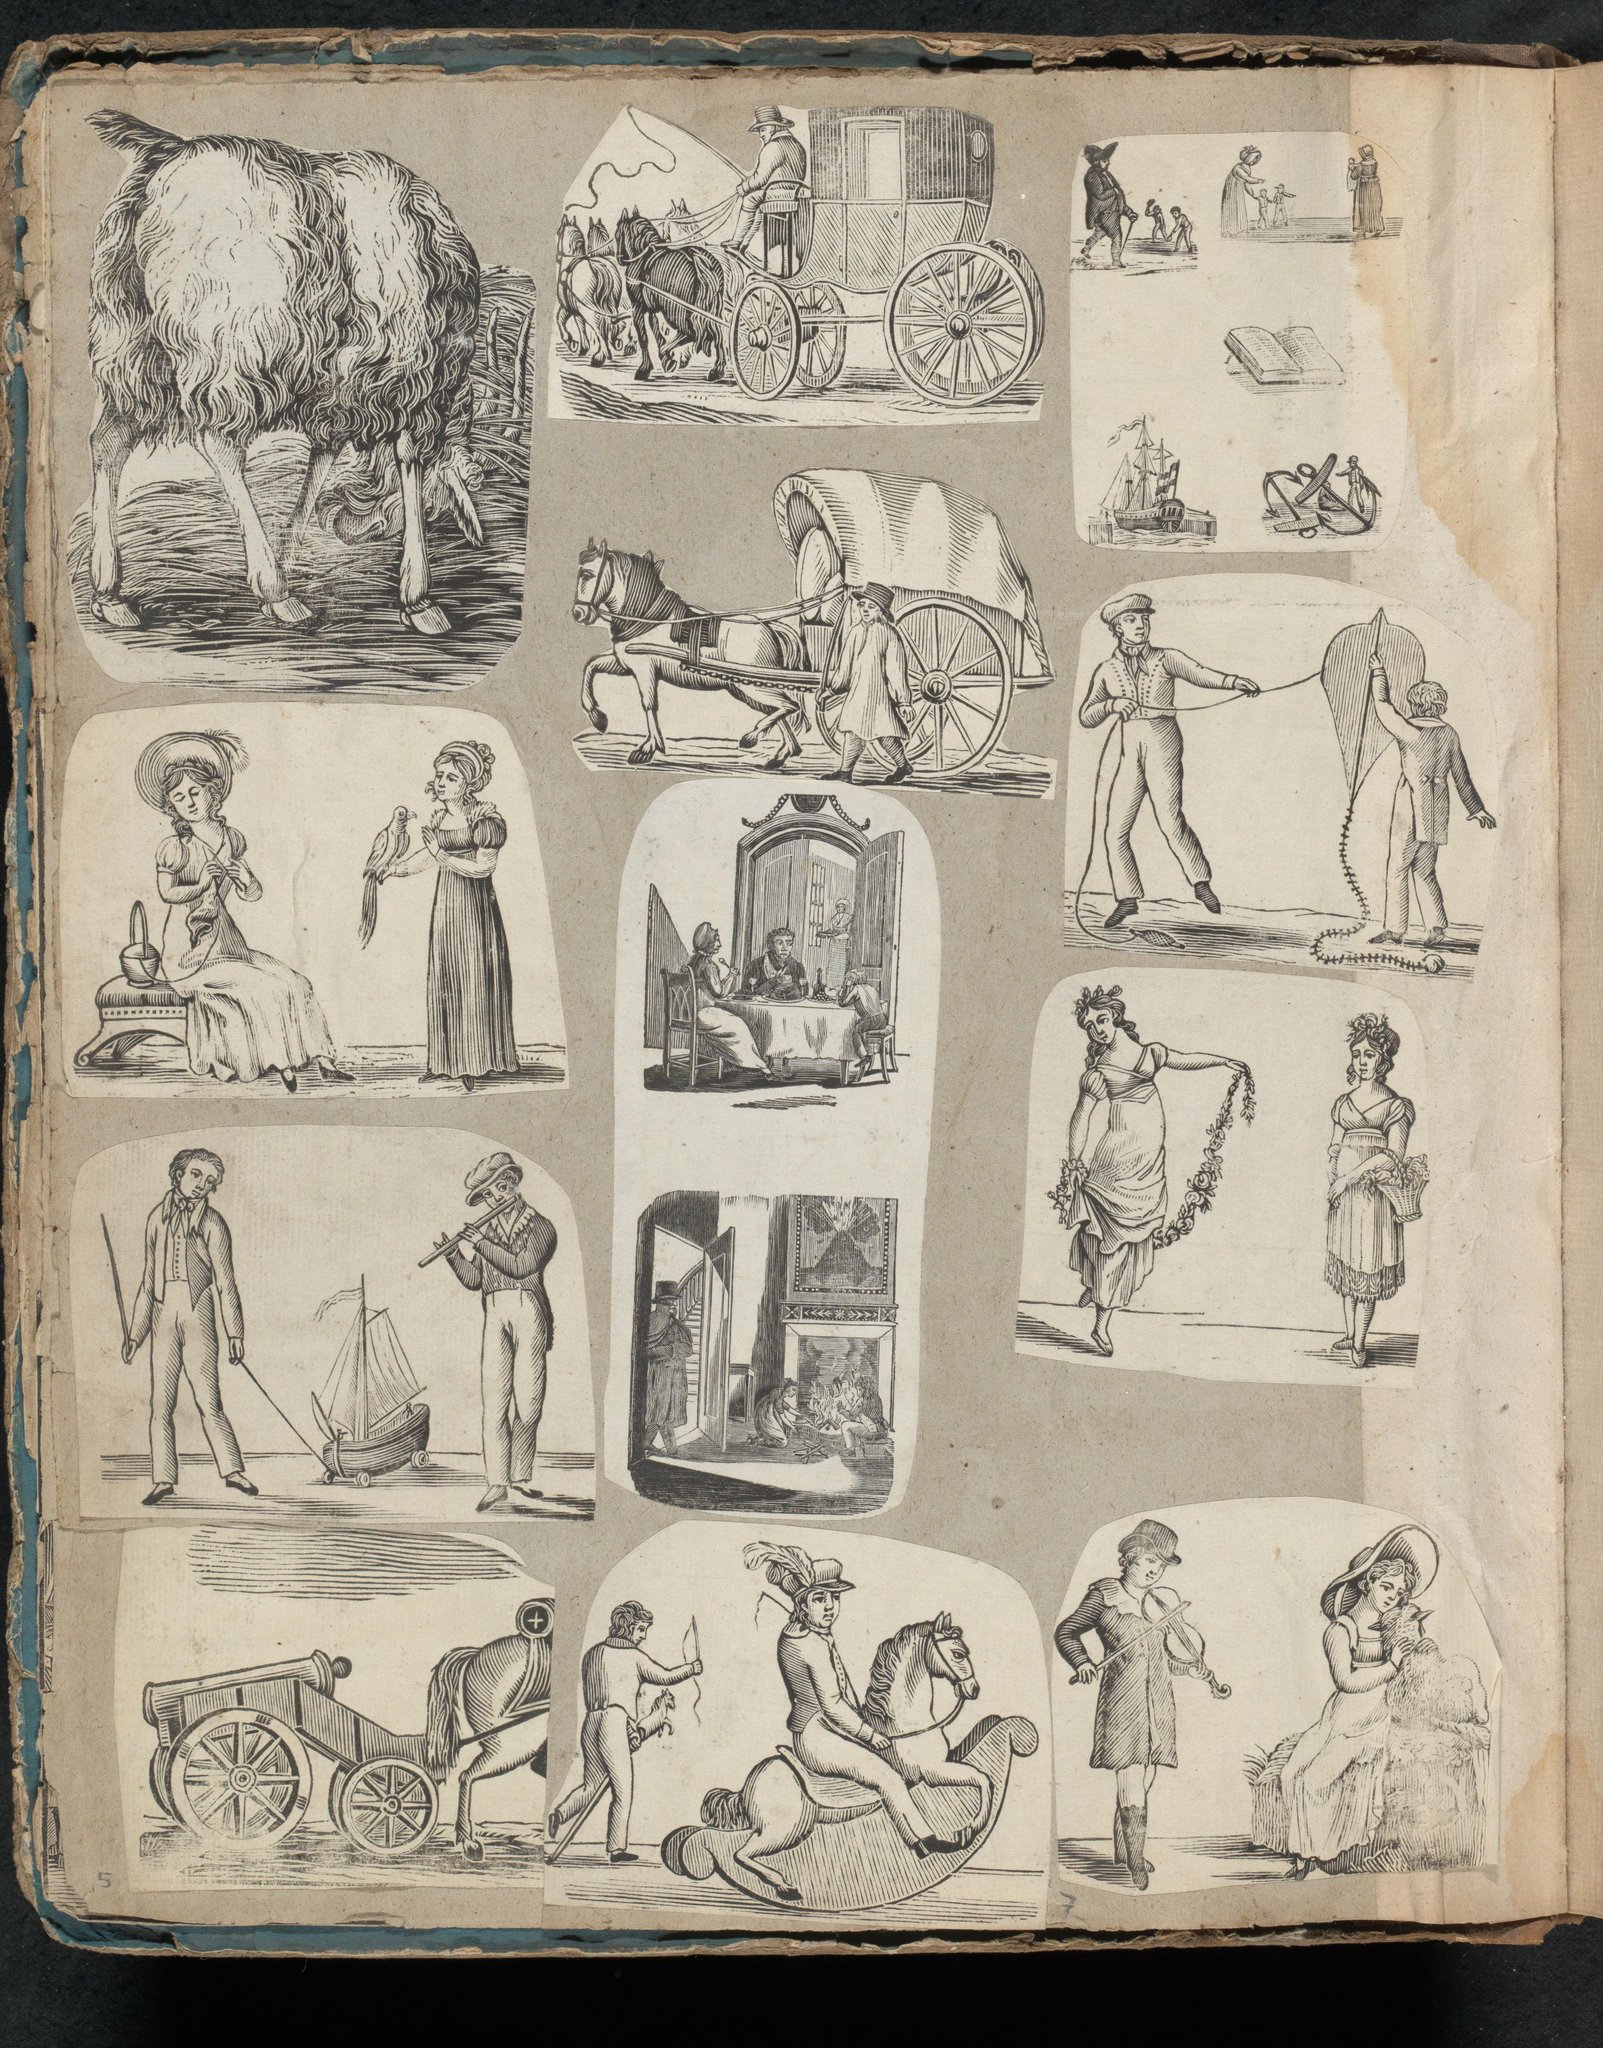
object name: album leaf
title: Albumblad met diverse voorstellingen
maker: alexander cranendoncq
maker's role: draughtsman, print maker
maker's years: 1799-1869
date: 1814-1869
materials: paper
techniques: snipping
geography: nijmegen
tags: children's games and plays, four-wheeled, animal-drawn vehicle, e.g.: cab, carriage, coach, child playing with animals, (flying a) kite, one person playing an instrument, goat, two-wheeled vehicle drawn by one animal, rocking-horse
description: Albumblad met 11 uitgeknipte voorstellingen uit voornamelijk volksprenten, onder andere van een bok, rijtuigen en kinderspelen. Hoek linksonder is uitgeknipt.